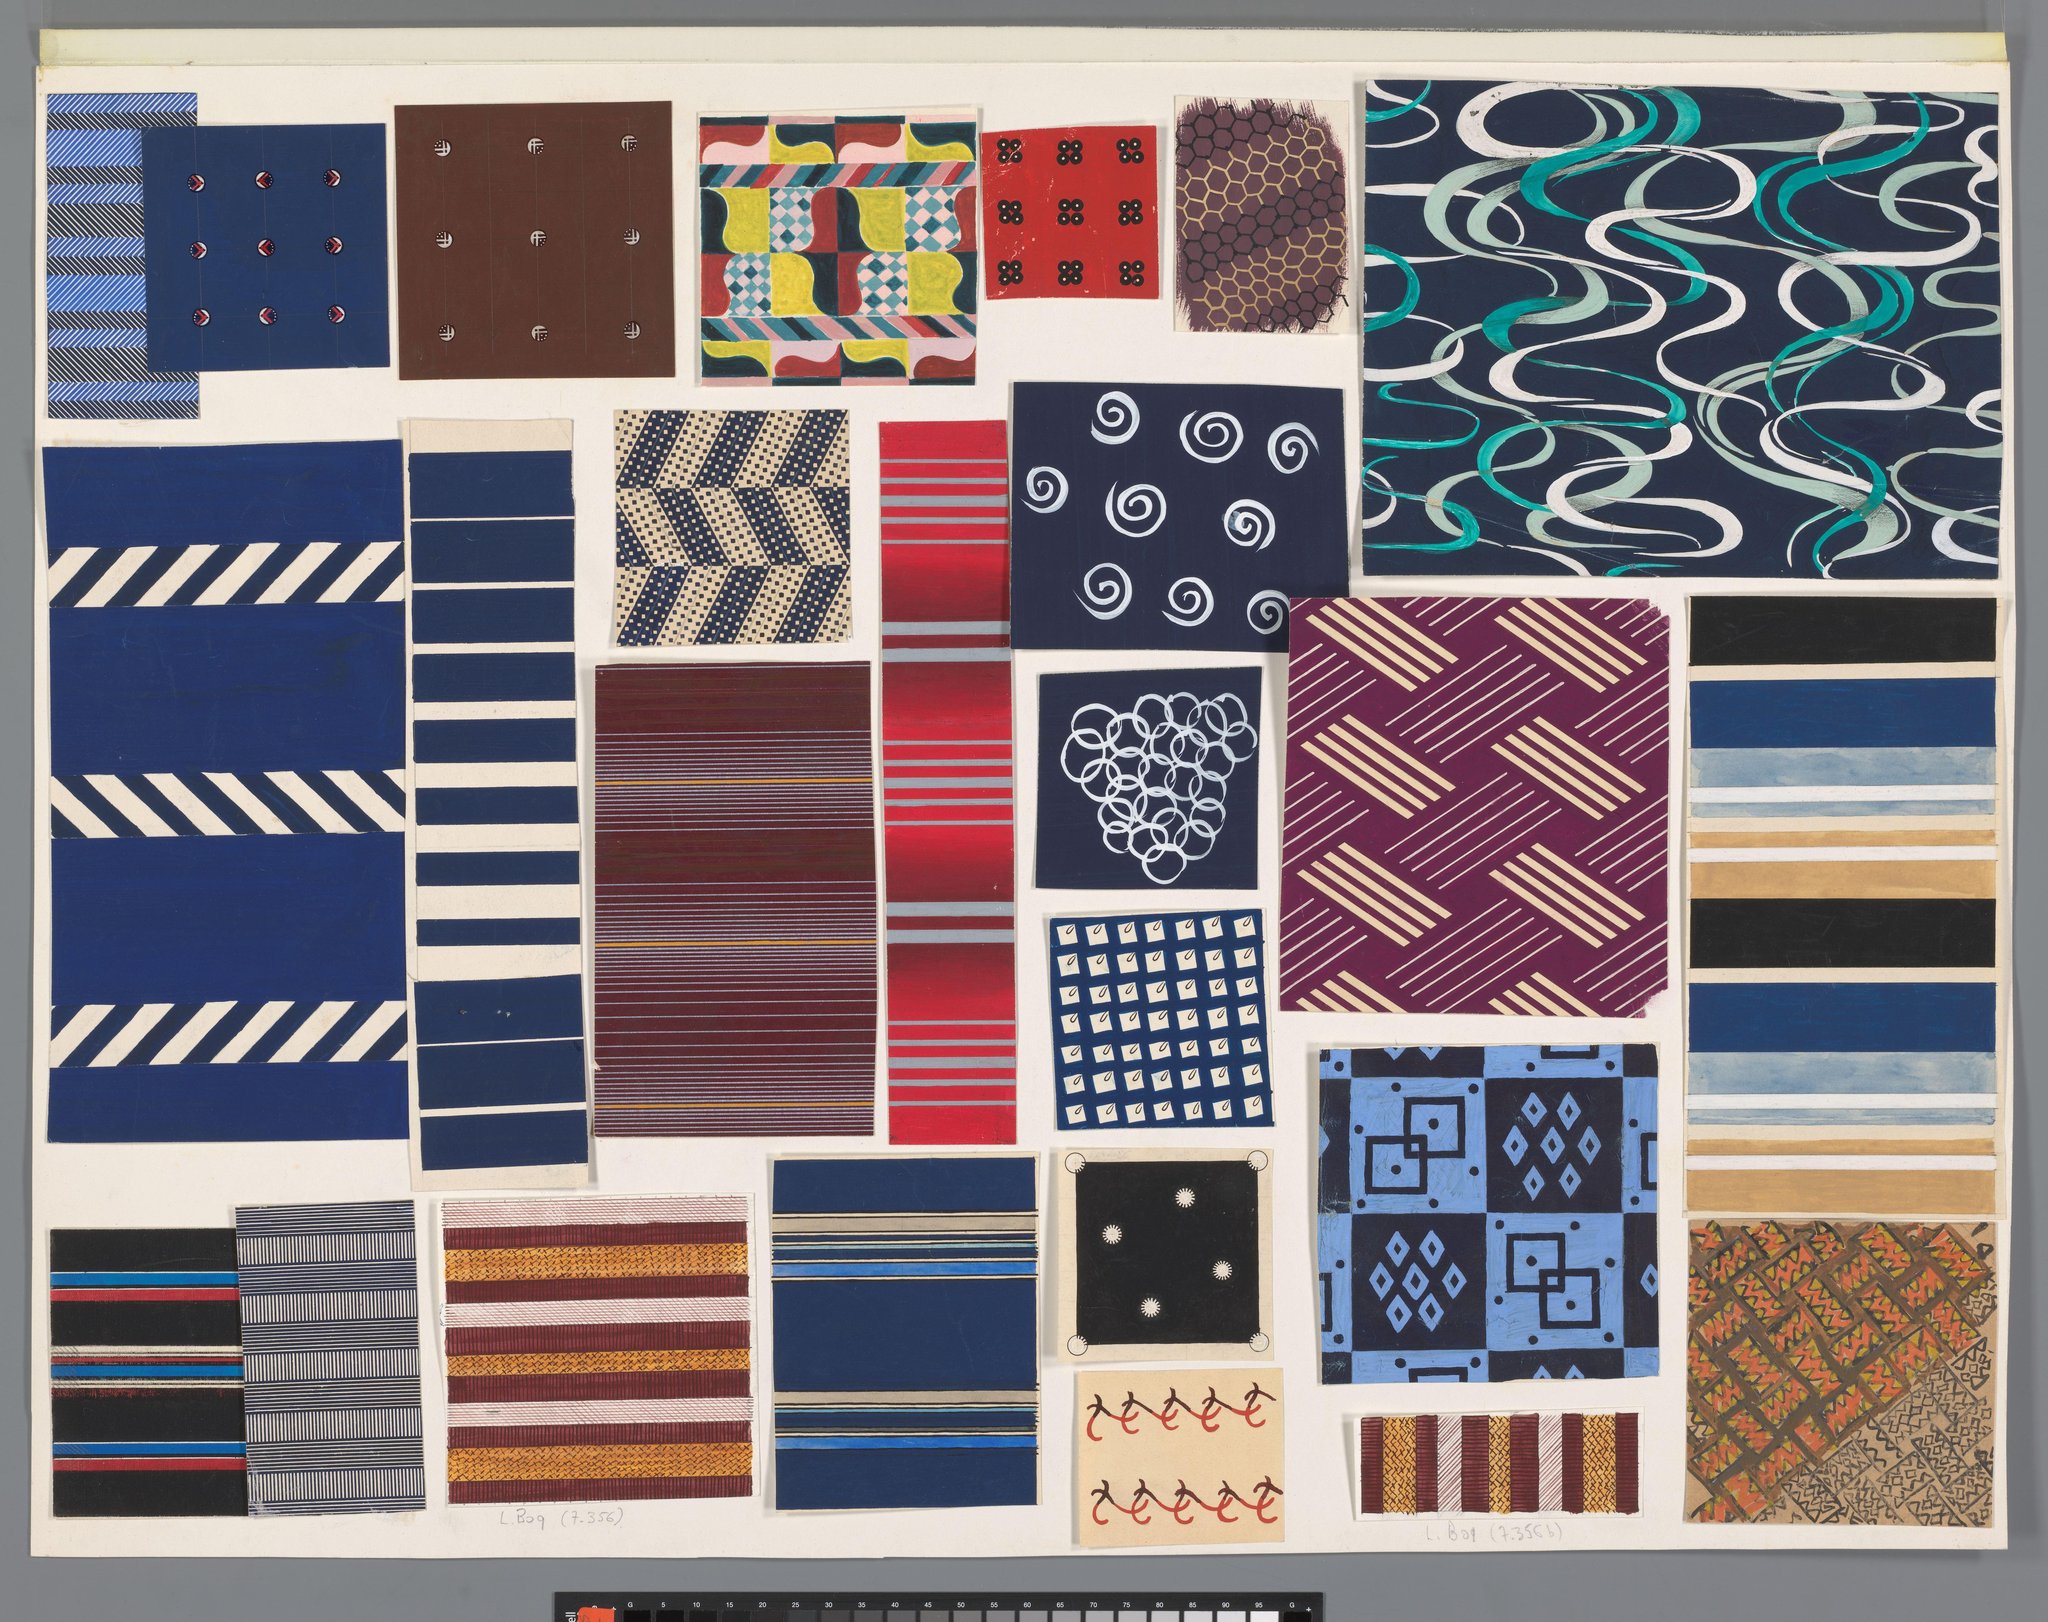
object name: design drawing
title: 26 Ontwerpen voor zijden stoffen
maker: Anonymous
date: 1940-1960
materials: gouache, paper, plastic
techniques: pasting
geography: lyon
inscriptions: inscription: ‘L.B09 (7.356) / L.B01 (7.356b)’